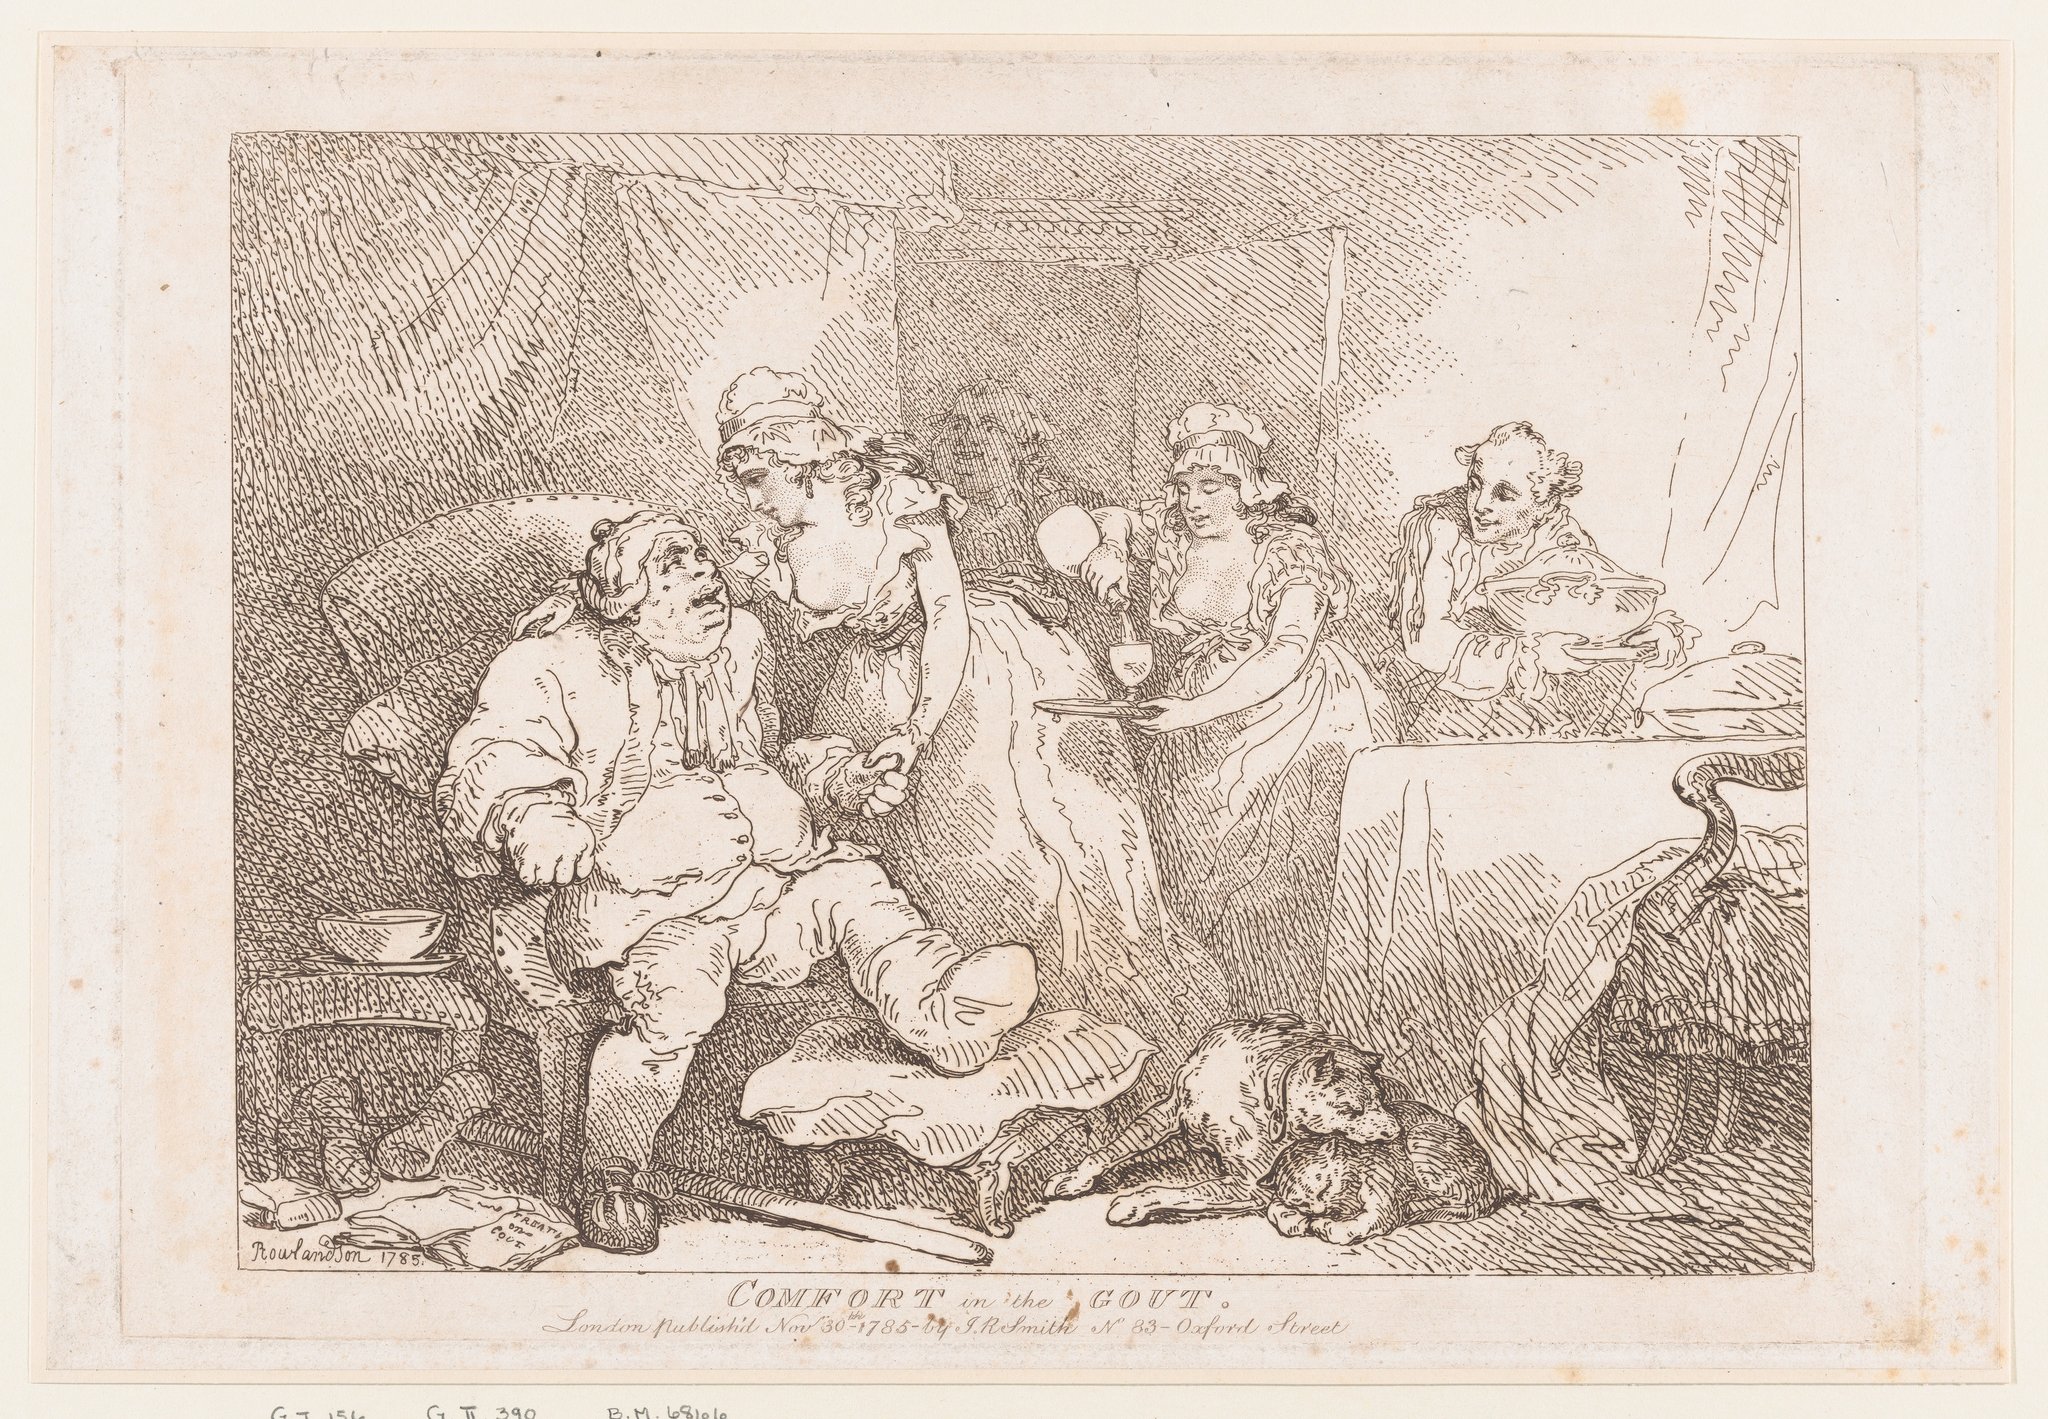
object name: print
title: Comfort in the Gout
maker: thomas rowlandson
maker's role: artist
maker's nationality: british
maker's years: 1757-1827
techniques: etching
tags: satire,illness,men,women,cats,dogs